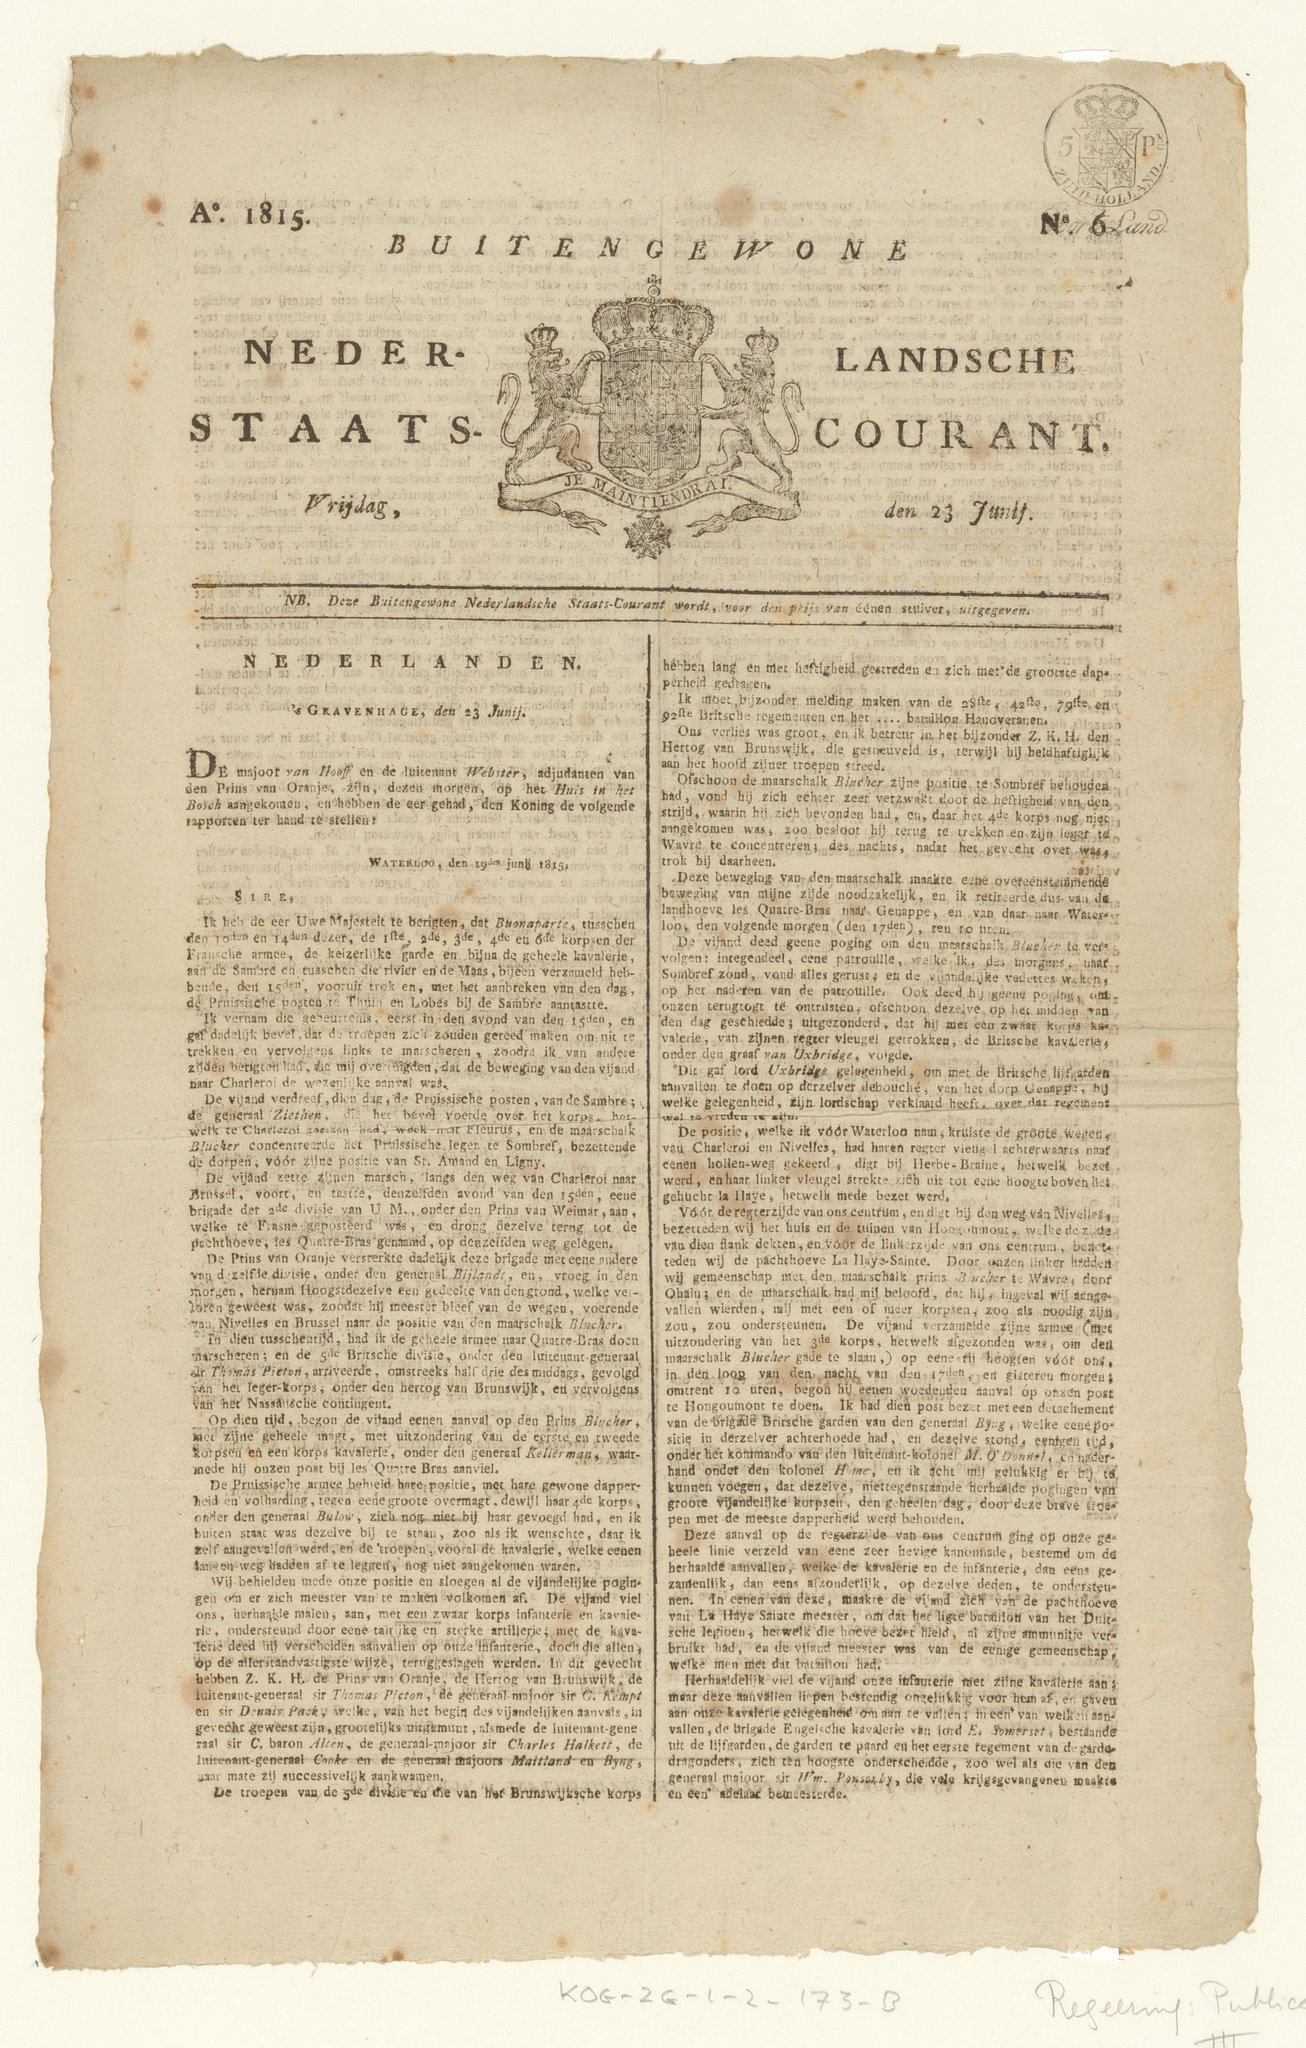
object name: newspaper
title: Buitengewone Nederlandsche Staatscourant, 23 juni 1815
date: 1815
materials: paper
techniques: letterpress printing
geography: the hague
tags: national government, newspaper, news-sheet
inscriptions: collector's mark, collector's mark: Lugt 1641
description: Exemplaar van de krant 'Buitengewone Nederlandsche Staatscourant' van 23 juni 1815 over de slag bij Waterloo. Gedrukte tekst op beide zijden met bovenaan het landswapen. Rechtsboven een stempel betaalde accijnzen. Onderwerpsrubrieken binnen de Atlas Zeden en Gewoonten: Regeering, Publicaties.